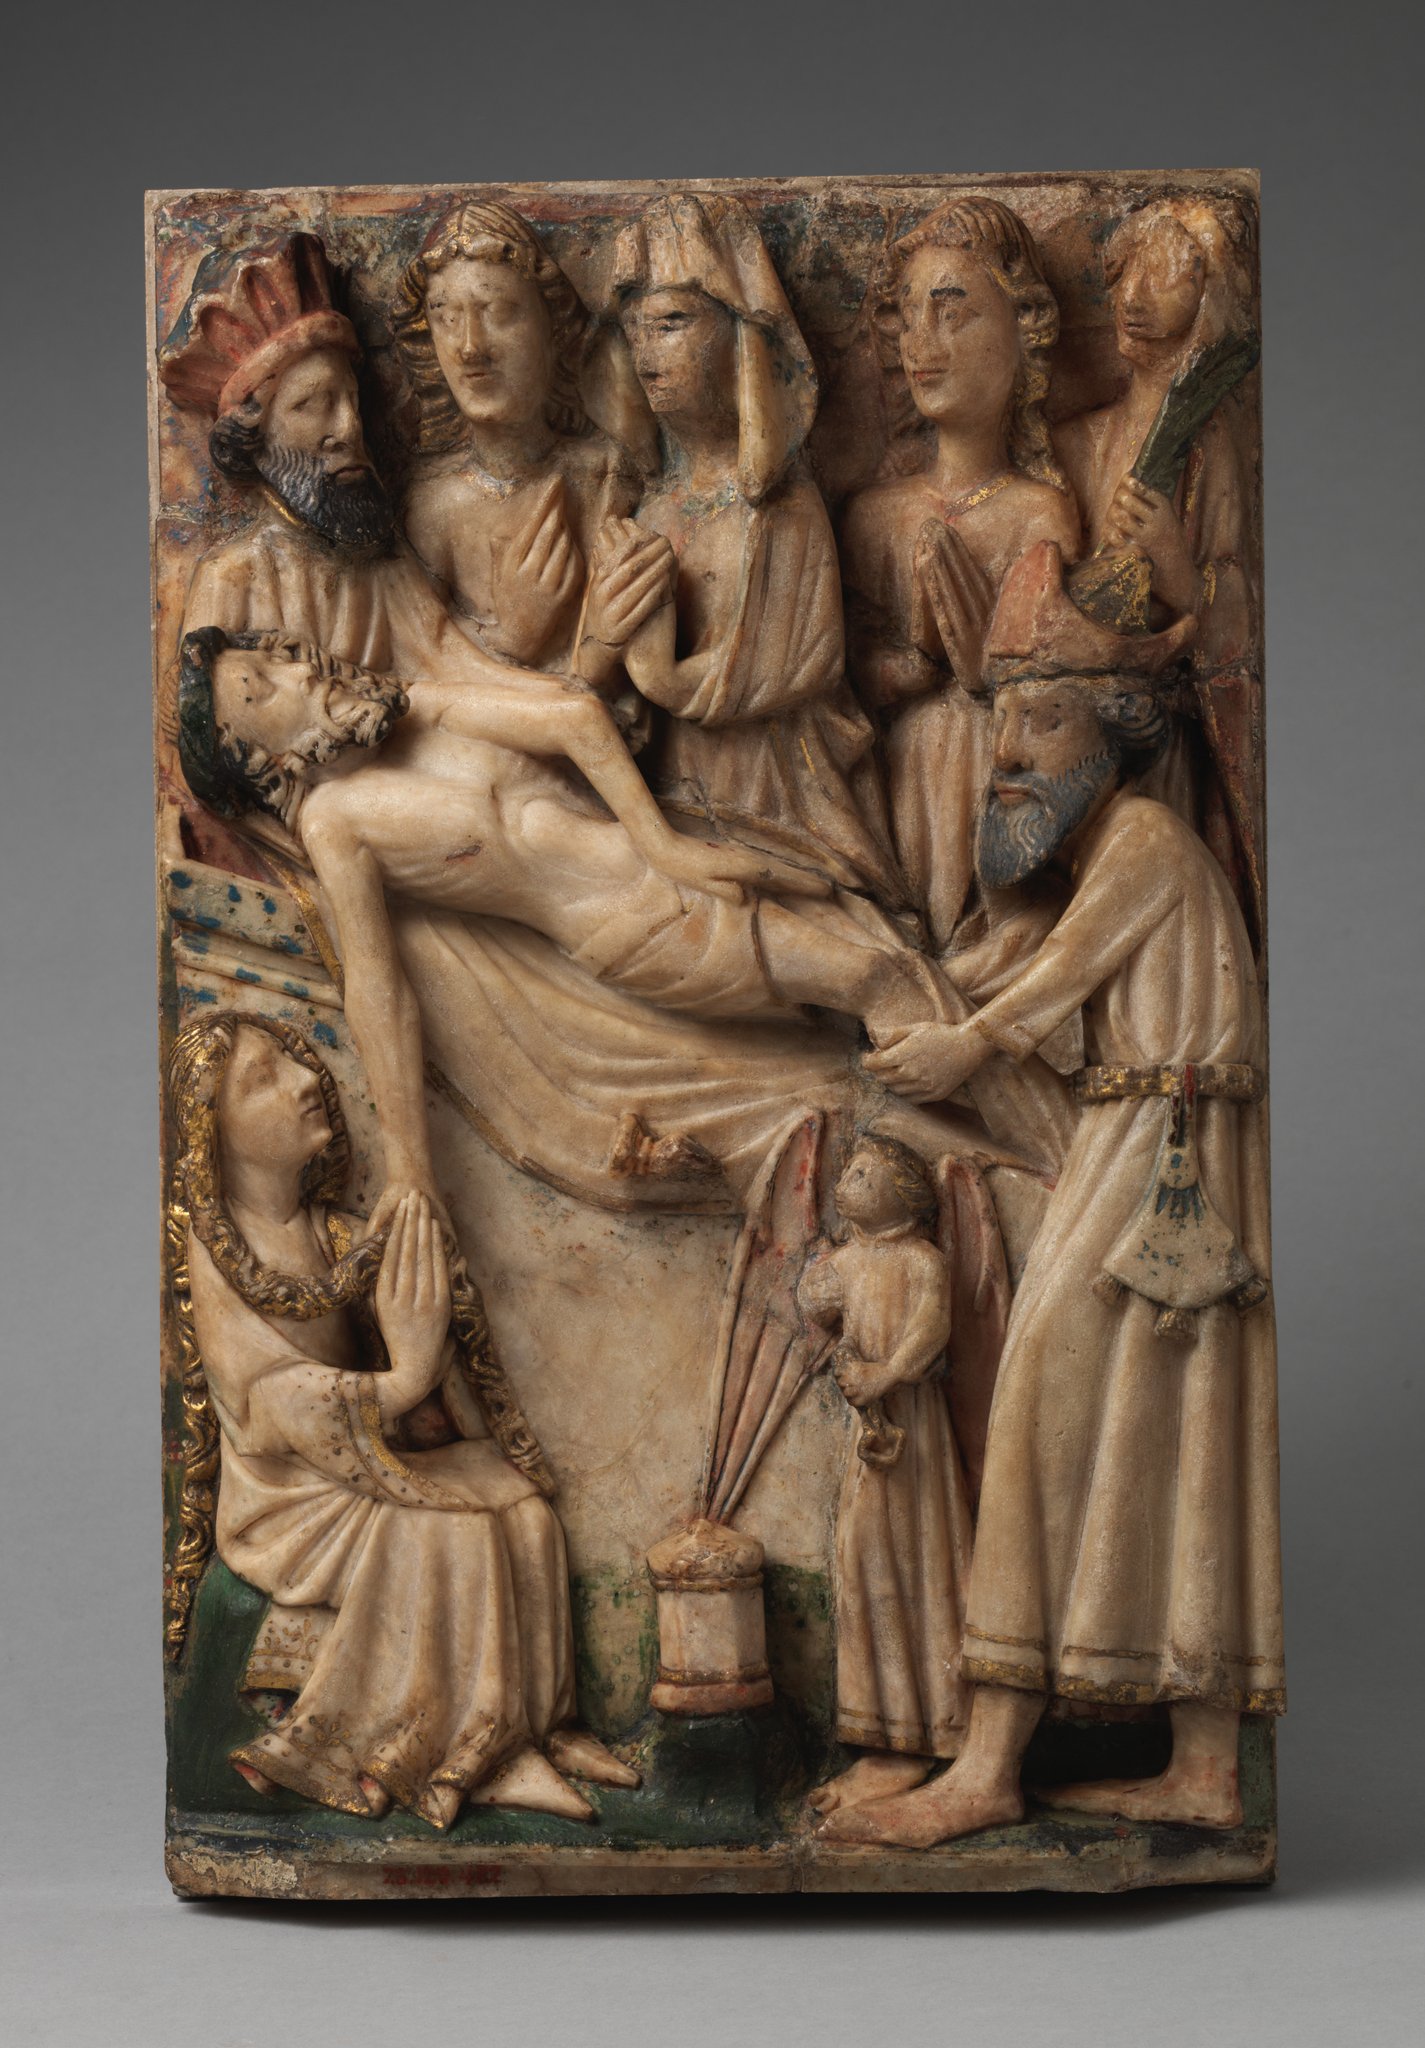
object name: relief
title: The Entombment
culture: british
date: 1401-1450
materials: alabaster, paint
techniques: gilding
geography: england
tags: men,angels,christ,mary magdalene,virgin mary,entombment